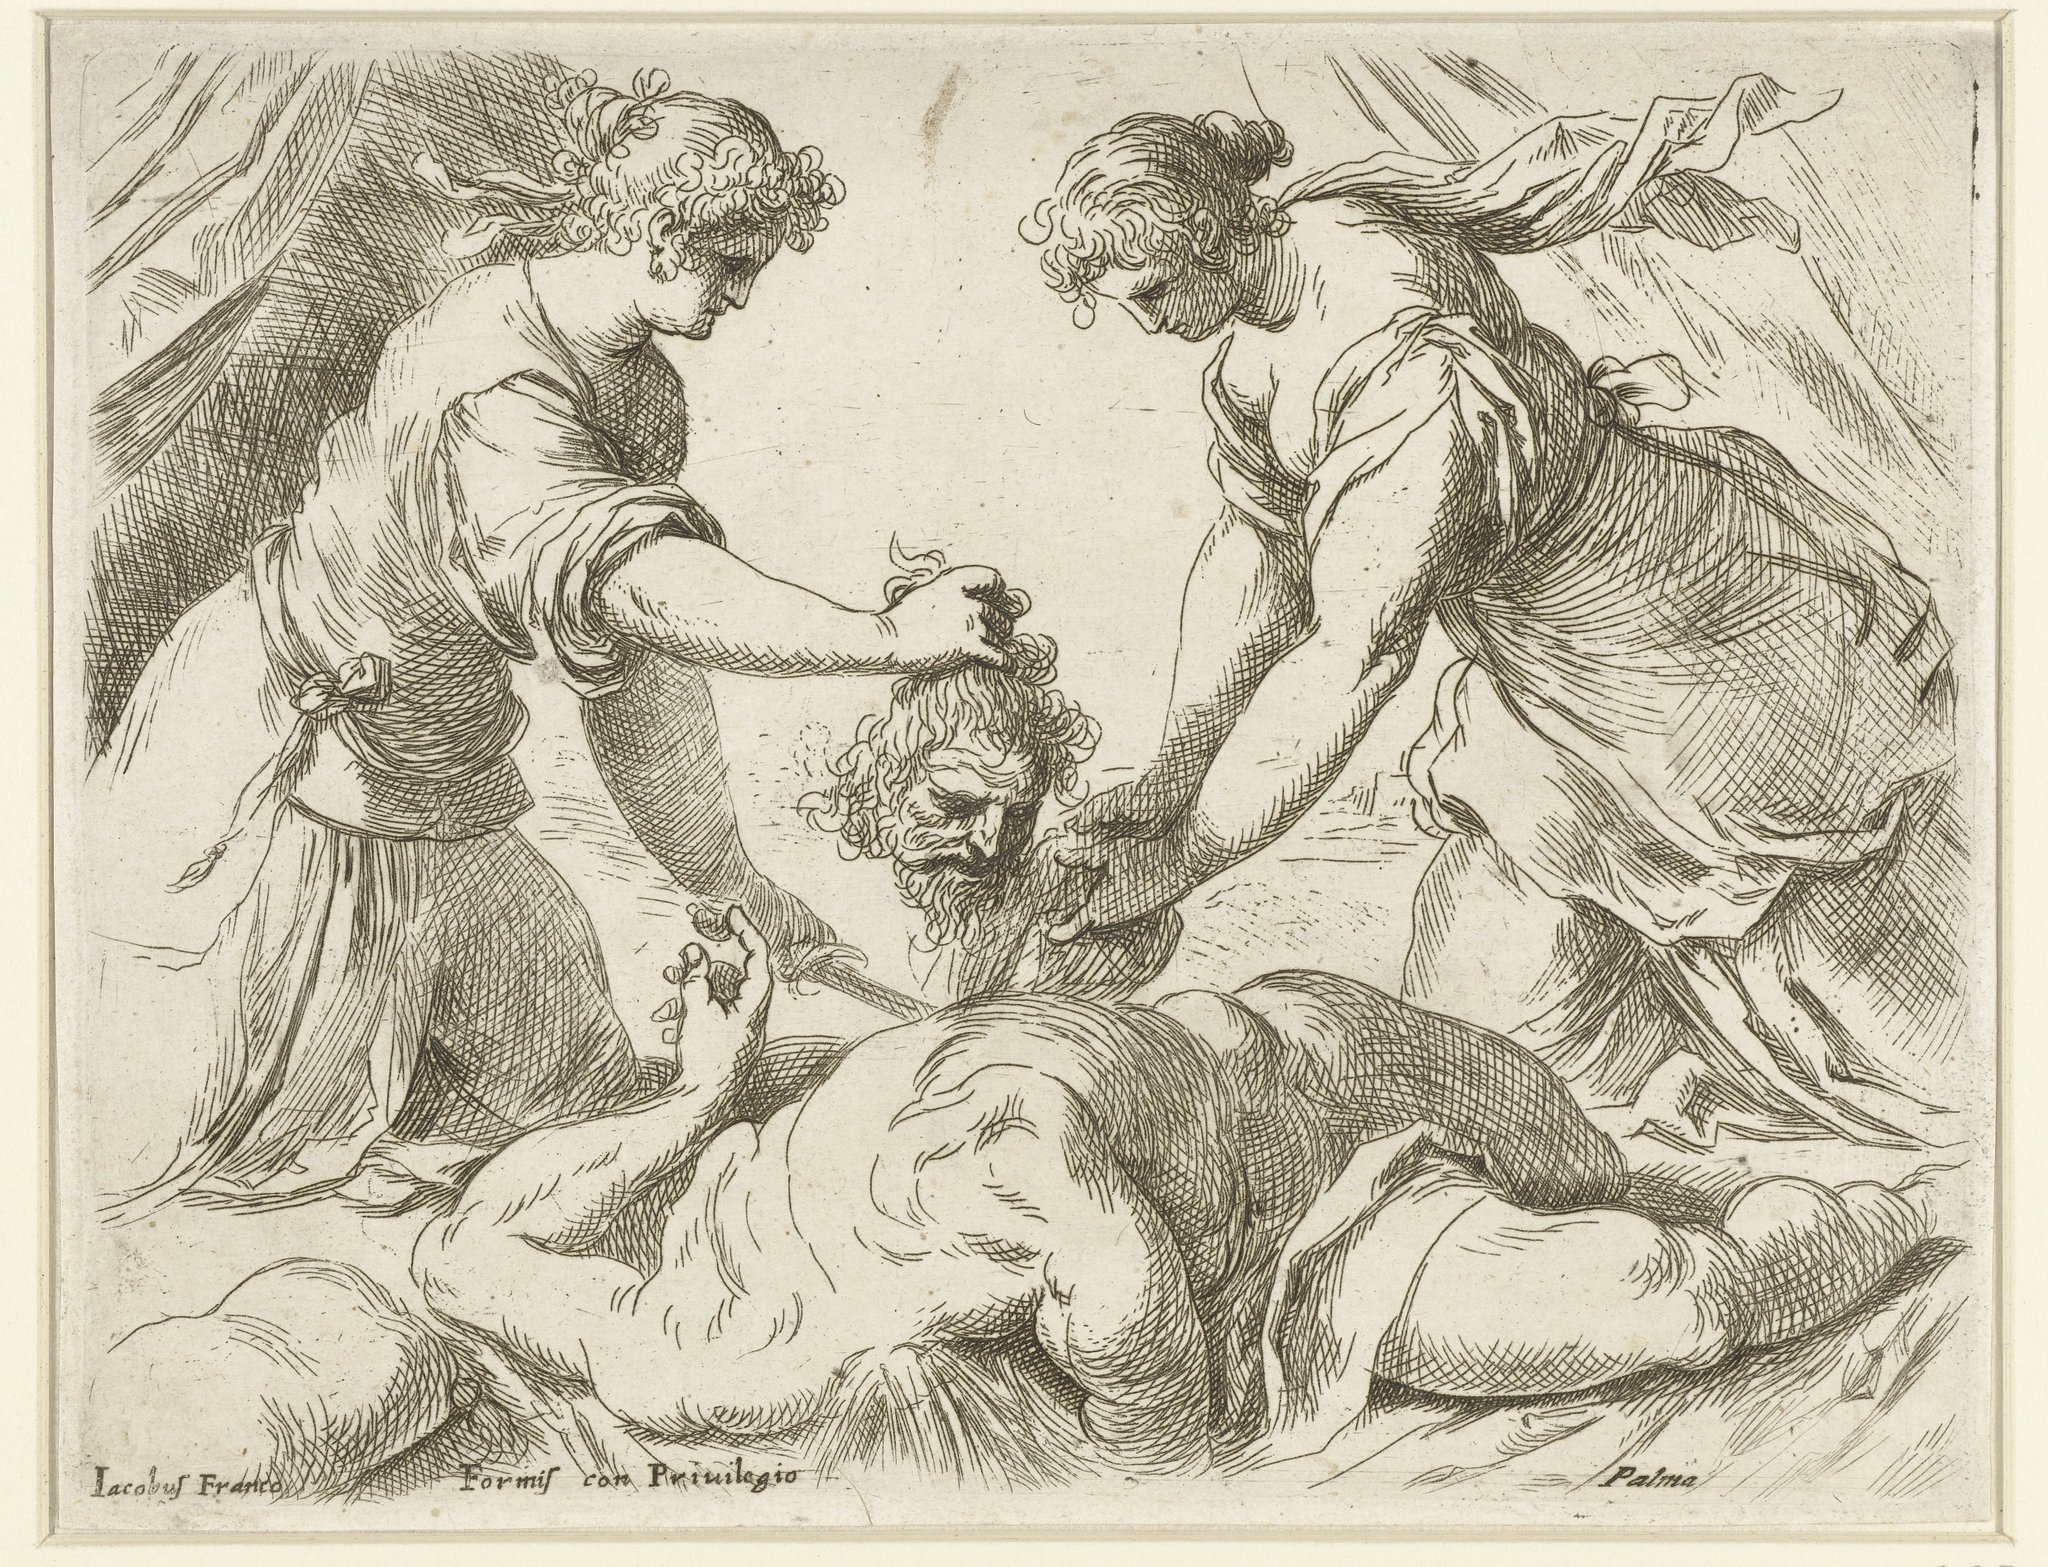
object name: print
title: Judith en Holofernes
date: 1554-1611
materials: paper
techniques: etching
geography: italy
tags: judith and her maidservant put holofernes' head in a sack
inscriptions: collector's mark: Lugt 2228, collector's mark: Lugt 2760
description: Een van de prenten uit De Excellentia et Nobilitate Delineationis Libri Duo, uitgegeven door Giacomo Franco in 1611.